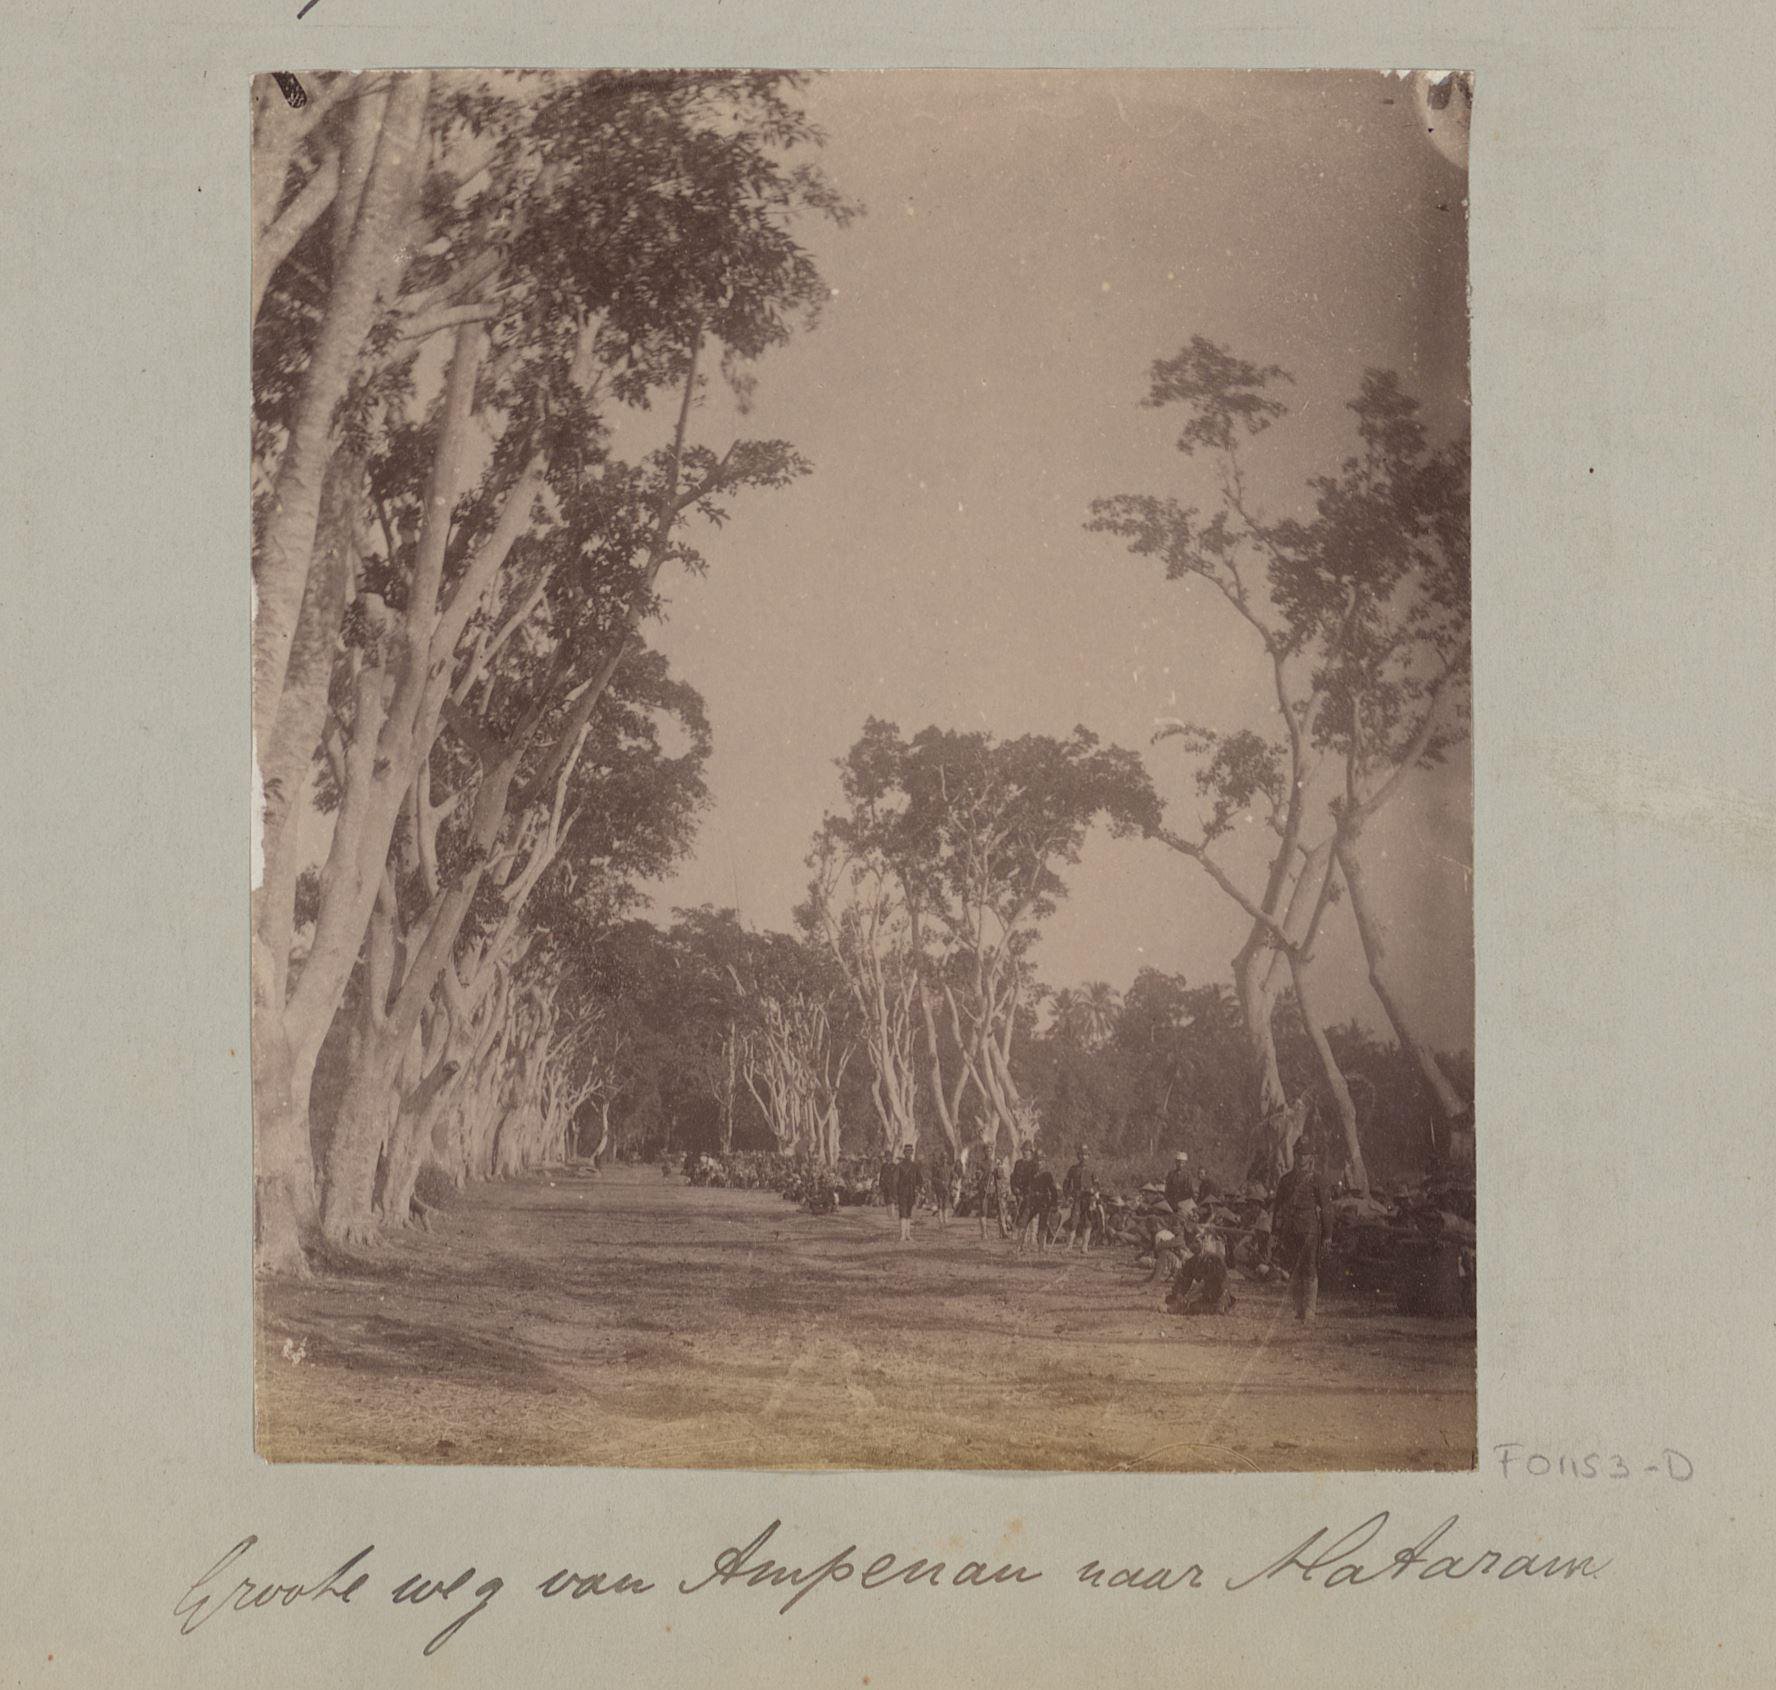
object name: album leaf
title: Soldaten op de grote weg bij Ampenan tijdens de Lombok-expeditie 1894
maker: christiaan johan neeb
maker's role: arts, fotograaf, officier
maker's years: 1860-1925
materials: photographic support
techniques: albumen print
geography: lombok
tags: the company, the unit, the troop ~ military service, road, path, dutch east indies, the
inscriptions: number: ‘4’